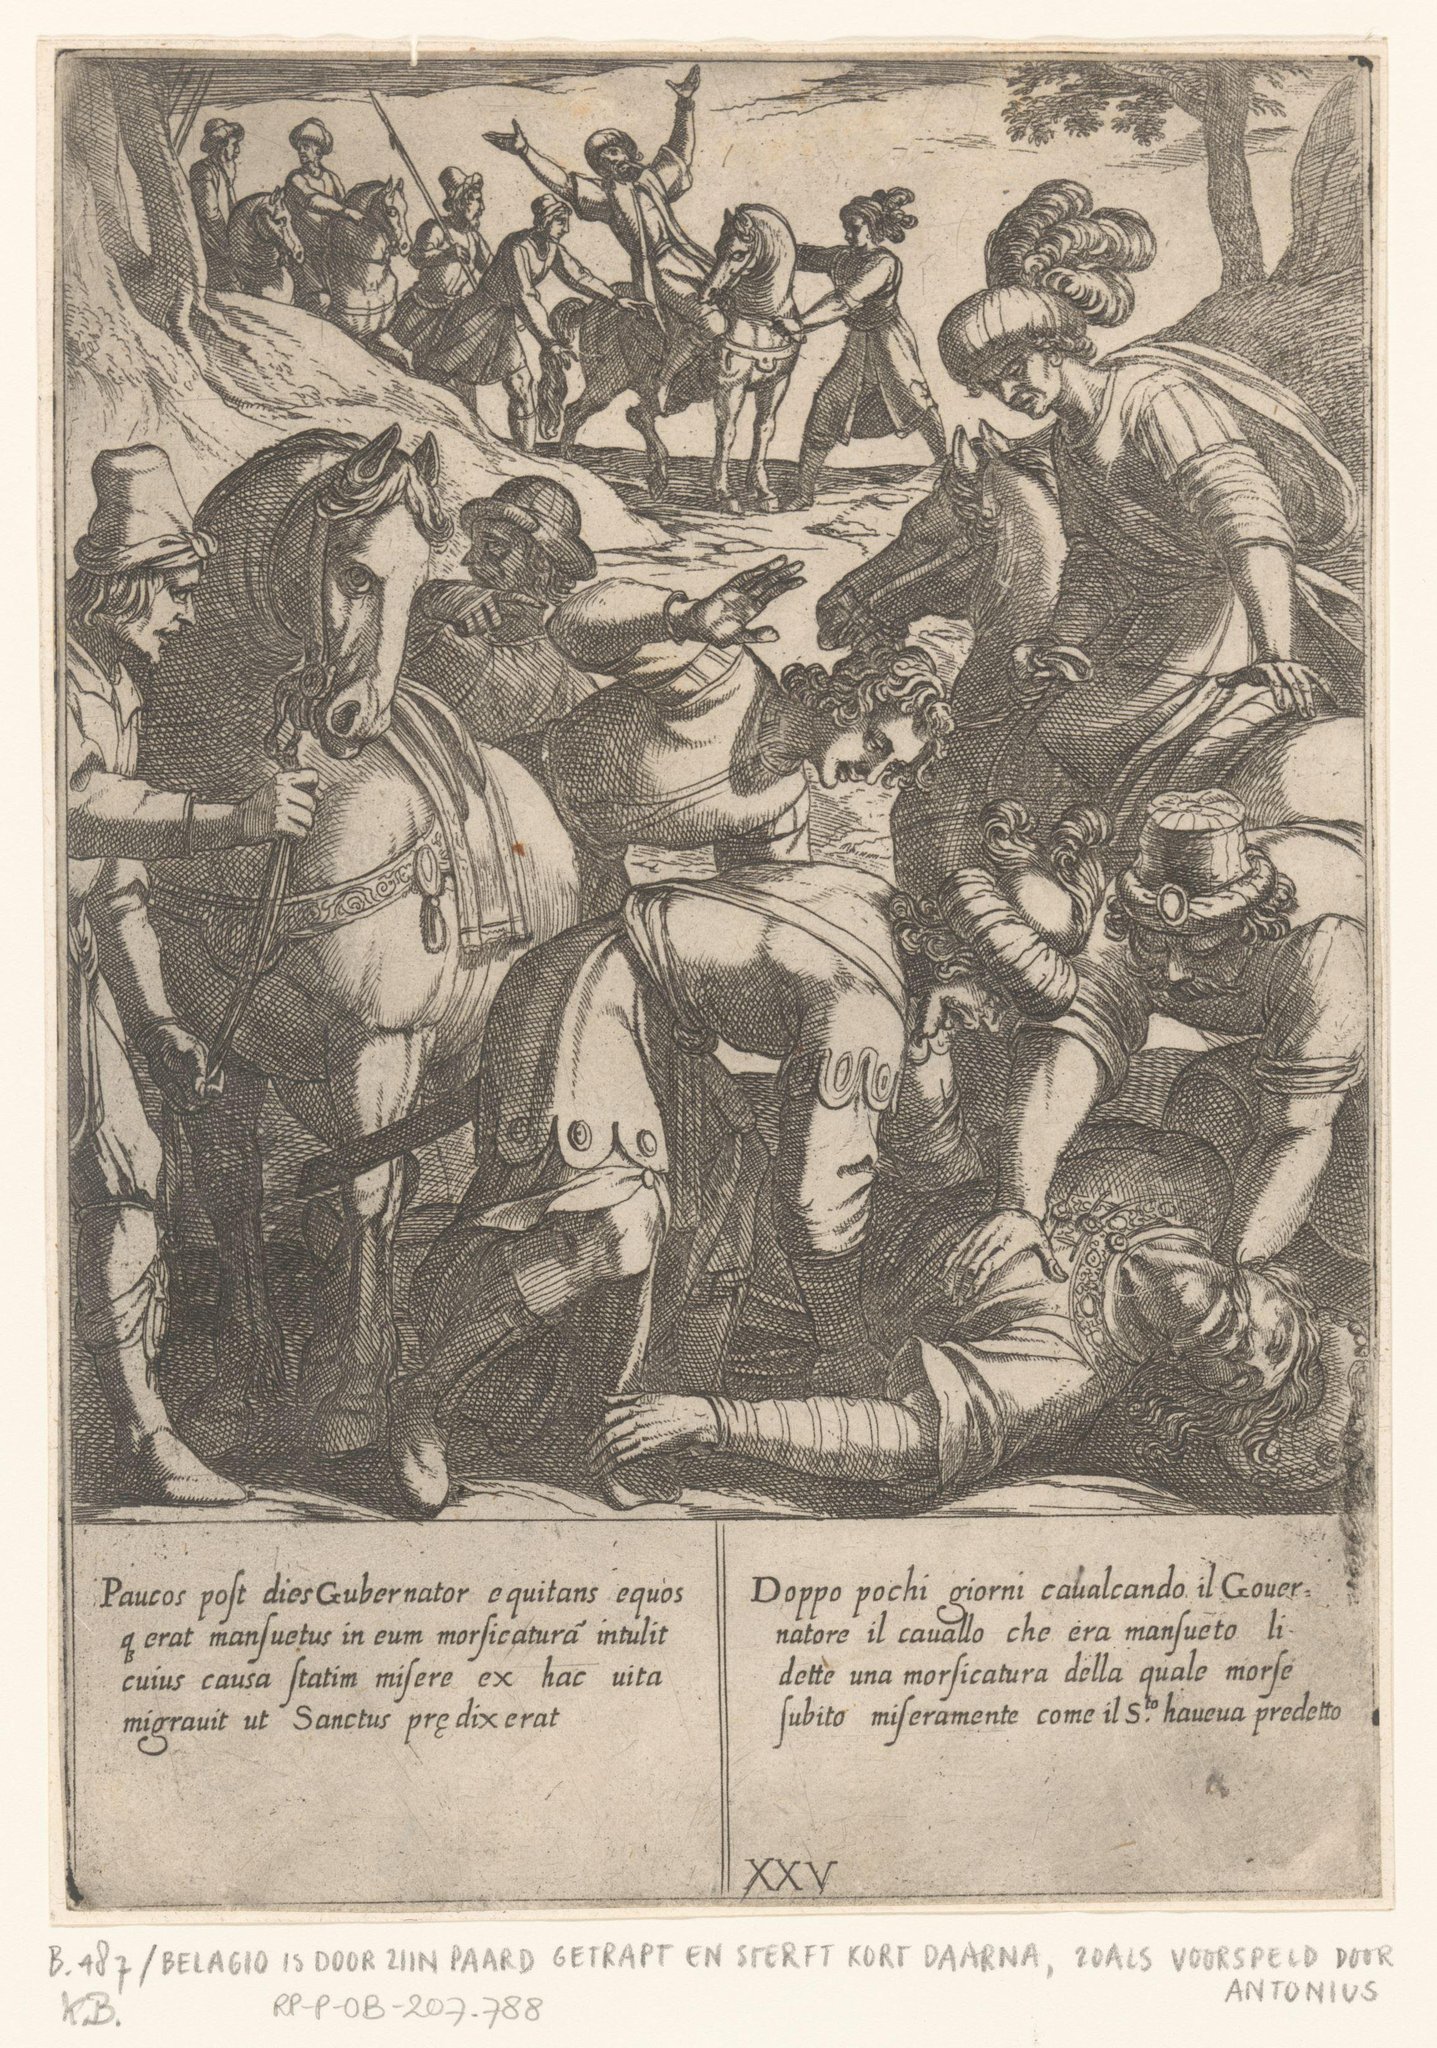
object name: print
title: Belagio wordt door zijn paard gebeten en sterft zoals voorspeld door H. Antonius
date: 1598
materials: paper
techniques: etching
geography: italy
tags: the hermit antony abbot (antonius abbas) of egypt, also called the great; possible attributes: bell, book, t-shaped staff, flames, pig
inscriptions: collector's mark: Lugt 240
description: Deze prent maakt deel uit van een reeks van 27 prenten (+ titelprent) over het leven van de heilige Antonius, naar een frescocyclus in de S. Antonio Abbate in Rome door Giovanni Battista Lombardelli en Niccolò Circignani.